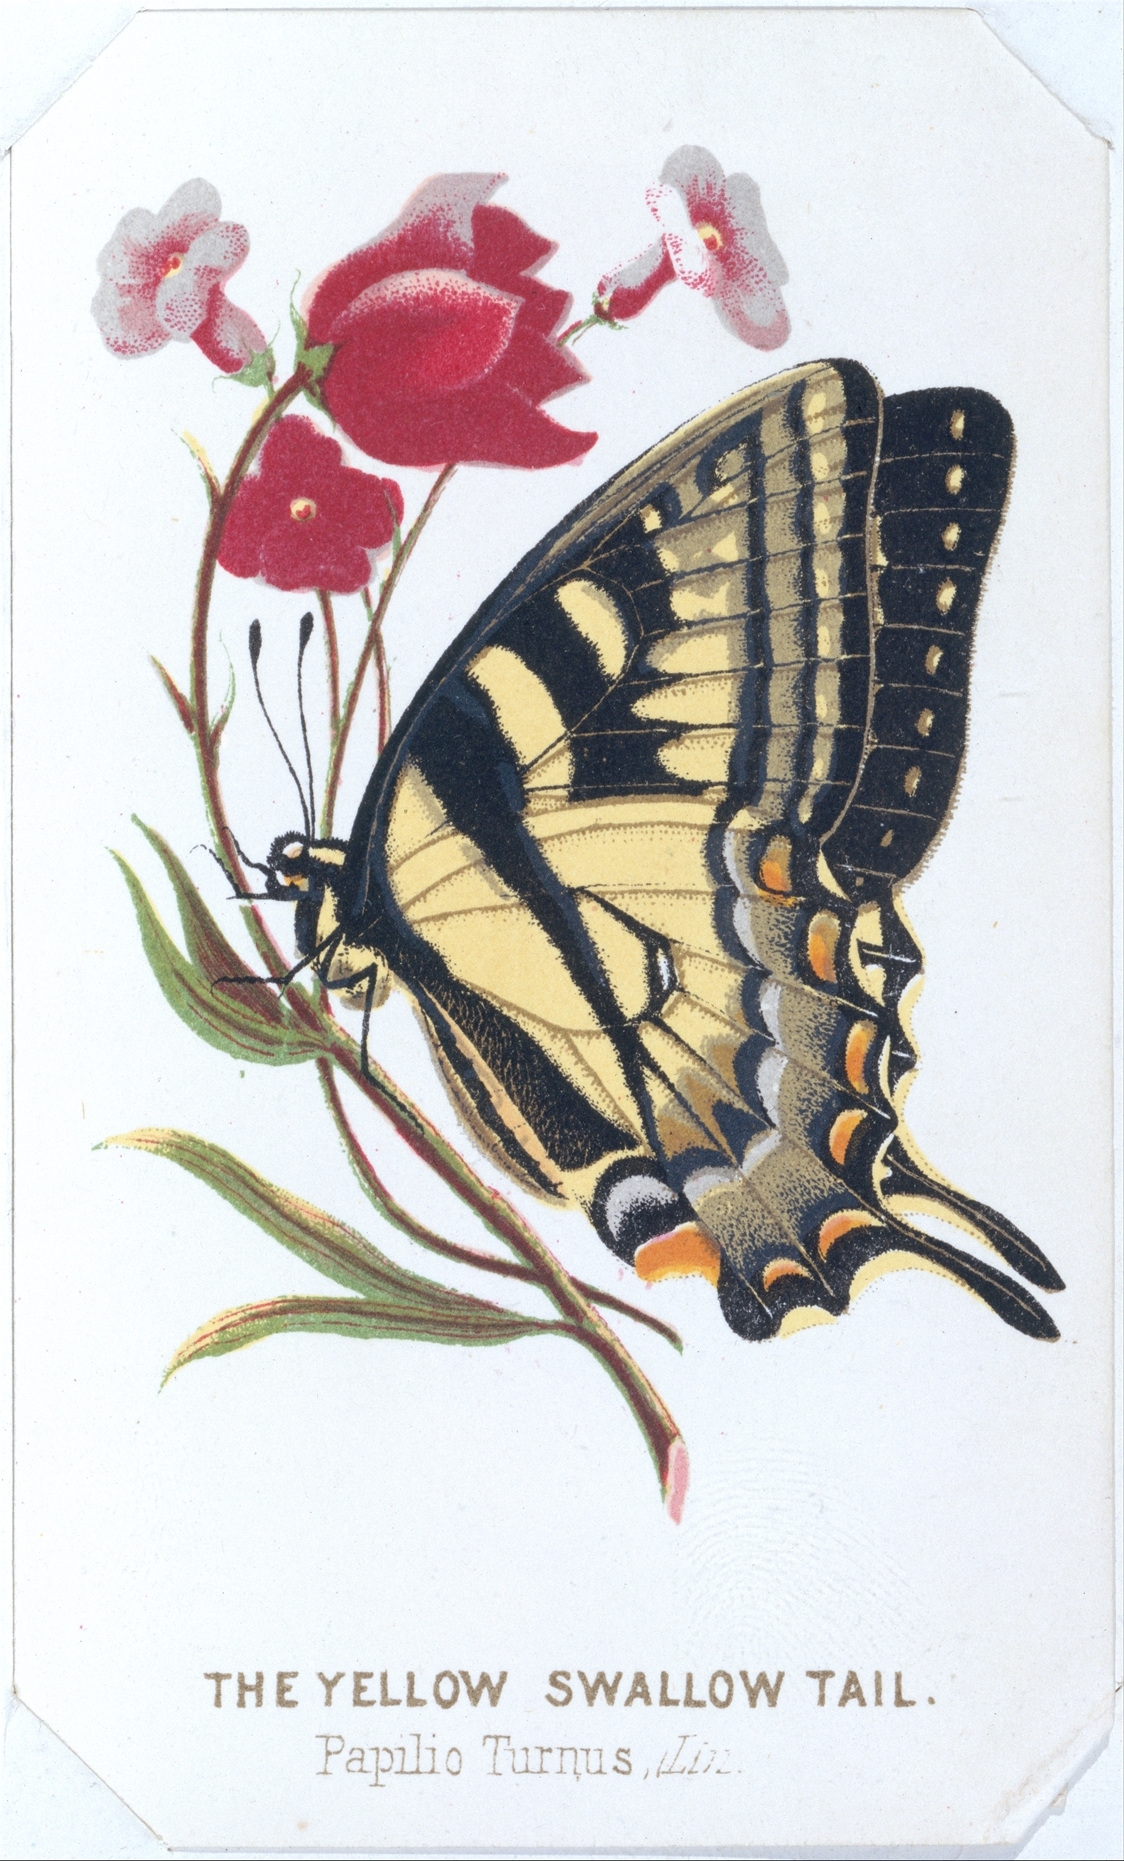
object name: print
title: The Yellow Swallowtail, from "The Butterflies and Moths of America", Part 2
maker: louis prang & co.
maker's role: publisher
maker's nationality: american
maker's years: 1800-1950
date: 1860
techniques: lithograph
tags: butterflies